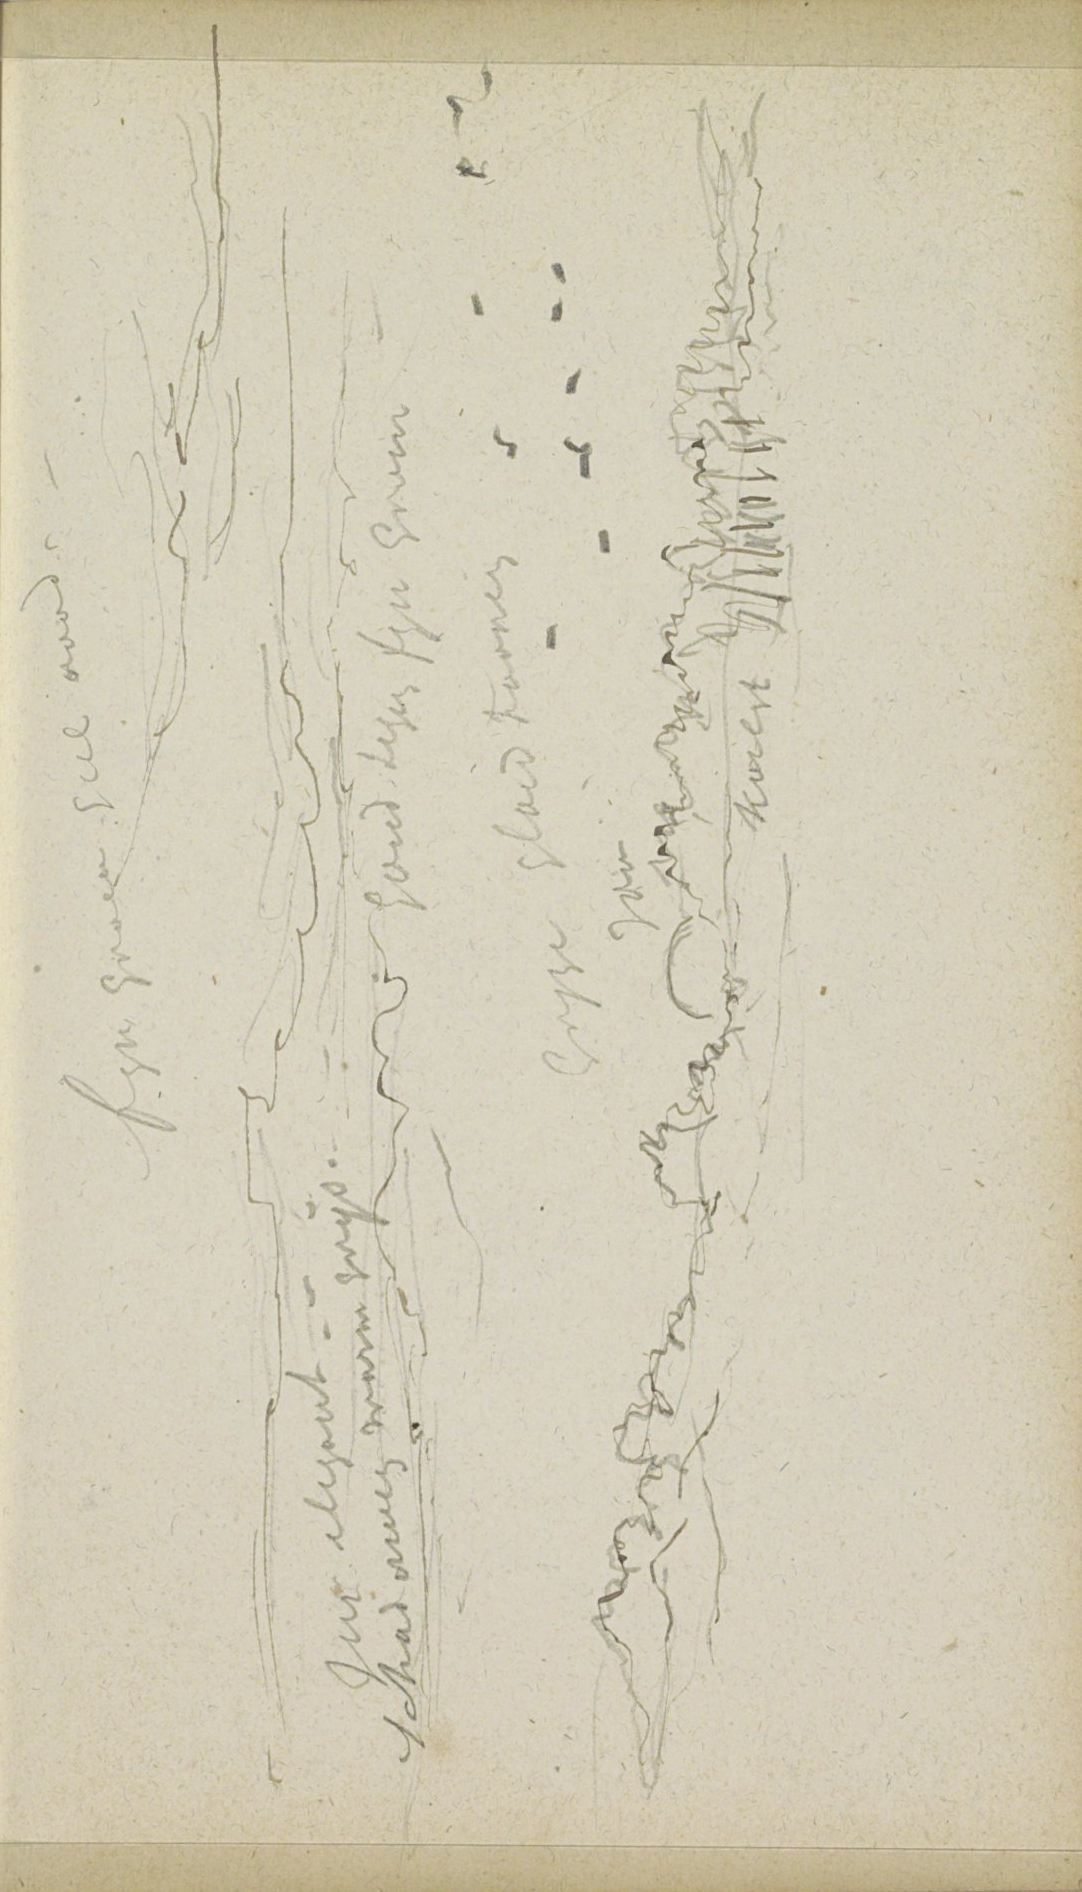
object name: sketchbook leaf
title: Landschap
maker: johannes tavenraat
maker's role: draughtsman, painter, print maker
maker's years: 1809-1881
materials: paper, pencil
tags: landscapes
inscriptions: kleurnotitie, handgeschreven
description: Blad 51 recto uit een schetsboek met 88 bladen.